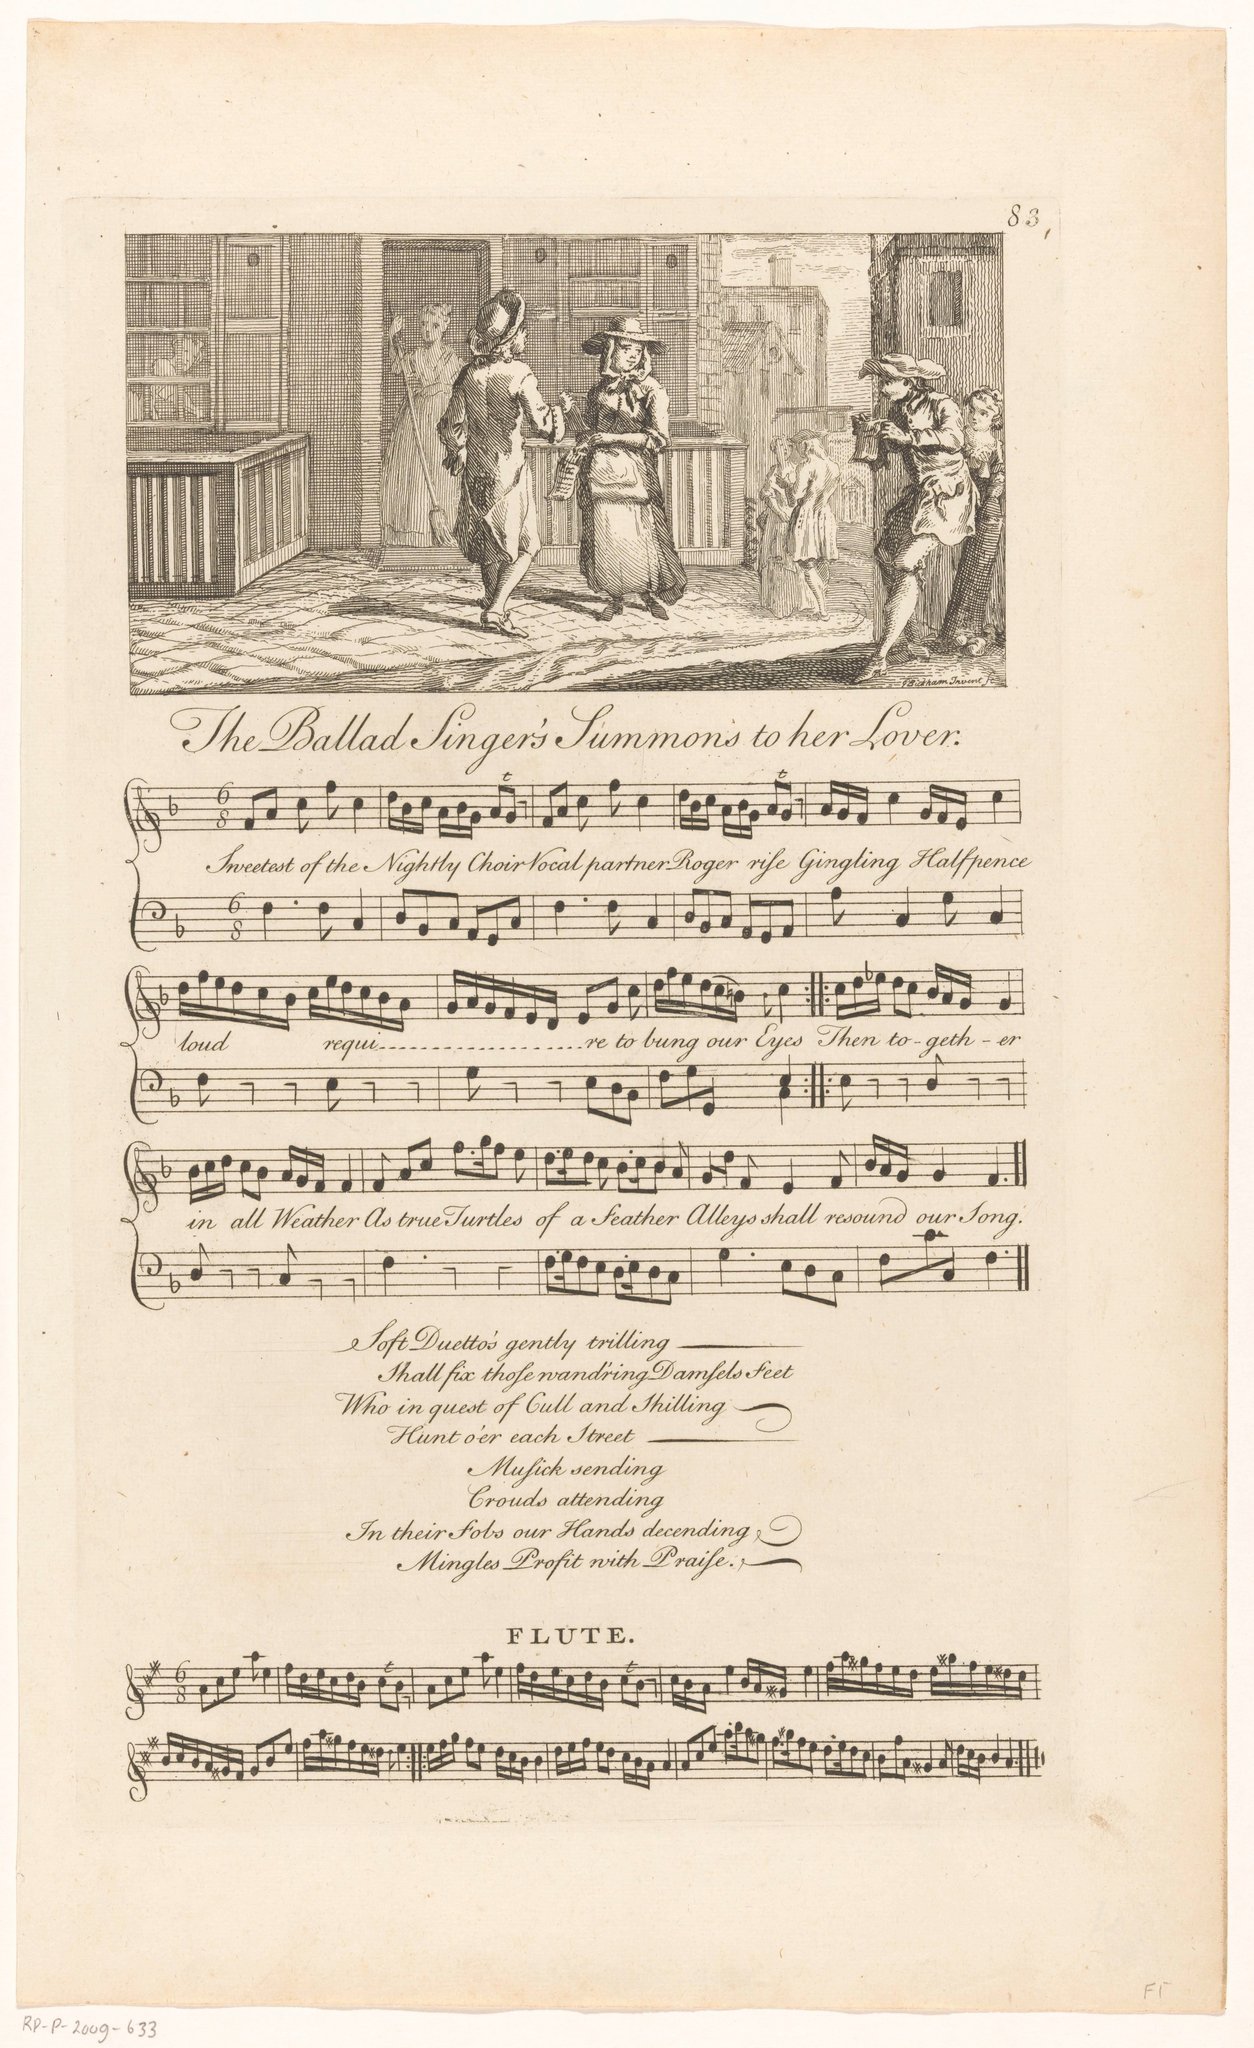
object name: print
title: The Ballad Singer's Summons to her Lover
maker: george bickham (ii)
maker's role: print maker, publisher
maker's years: 1706-1771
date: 1737-1740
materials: paper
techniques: engraving, etching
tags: street-trader, popular music, street music - cc - out of doors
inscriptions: collector's mark: Lugt 2228, collector's mark: Lugt 4780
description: Bladmuziek voor een liefdeslied voor zangstem, basso continuo en fluit. Er boven als illustratie een straatscène met in het midden een jongen en een meisje, waarschijnlijk met vellen bladmuziek in de hand. In dezelfde straat twee andere paren, op de achtergond een vrouw met bezem in de deuropening.